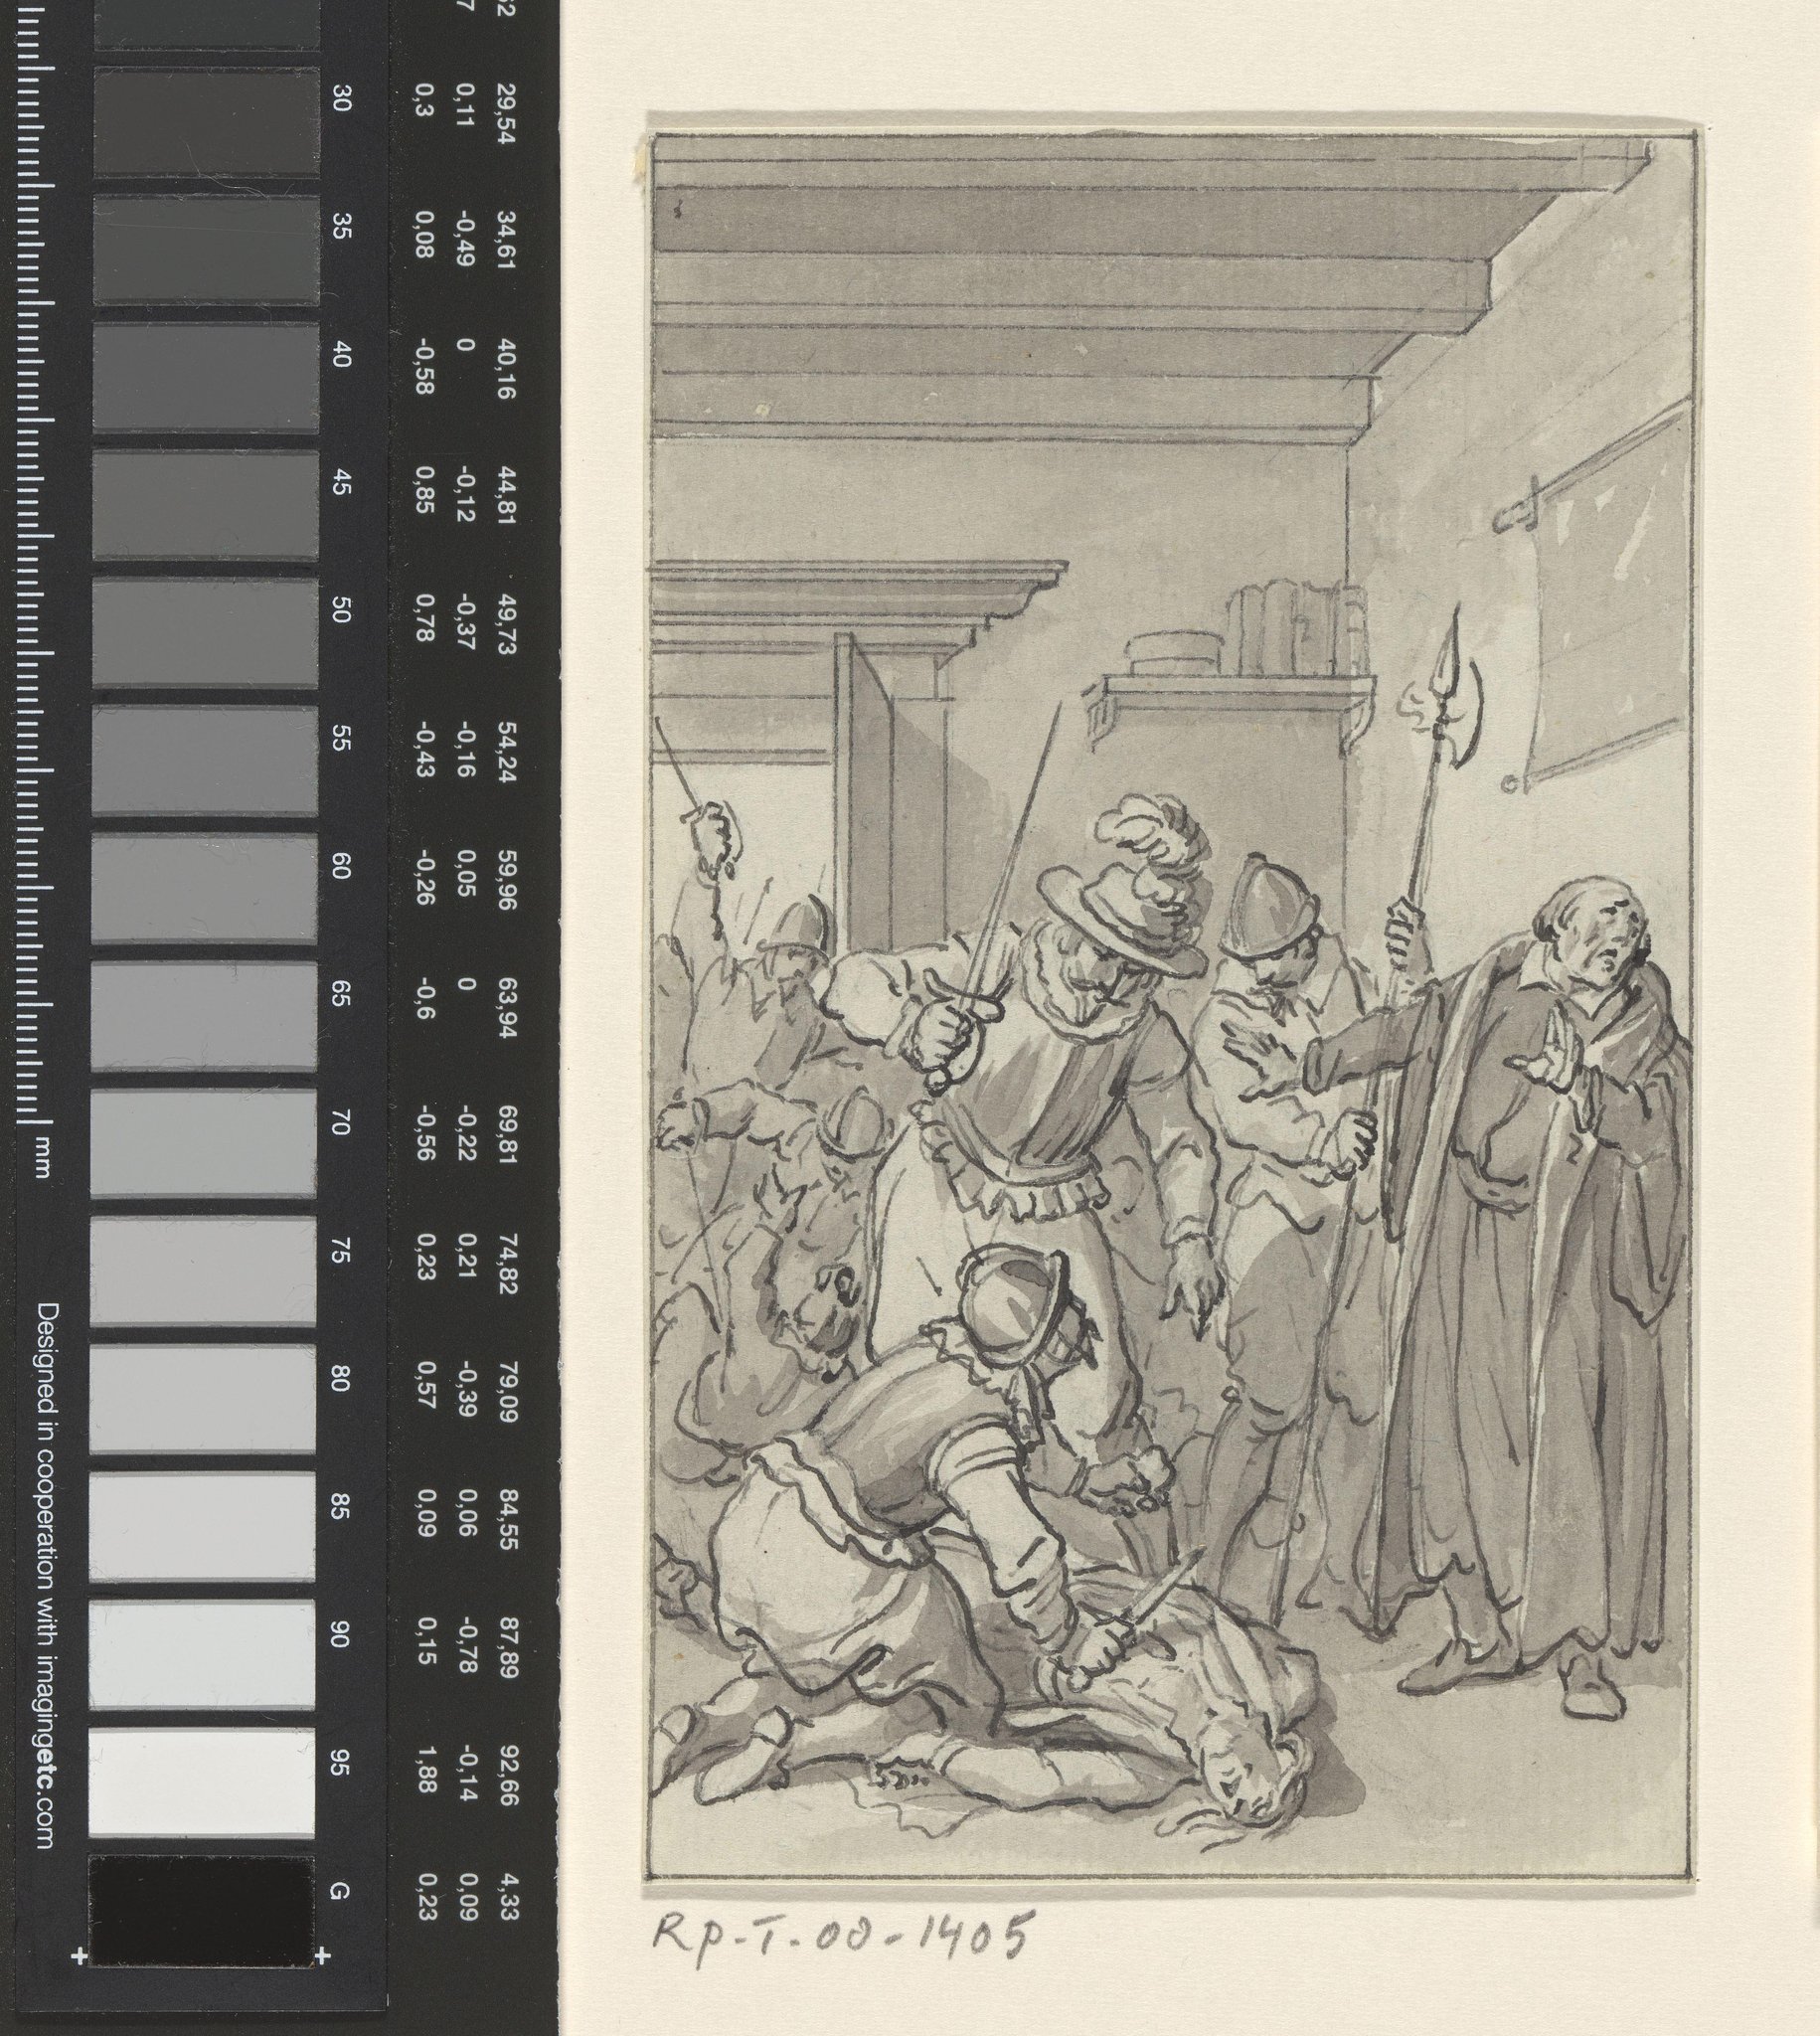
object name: history print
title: Mishandeling van de zoon van de geleerde Hortensius door de Spanjaarden te Naarden, 1 december 1572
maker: jacobus buys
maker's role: draughtsman, print maker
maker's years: 1724-1801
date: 1788-1790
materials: ink, paper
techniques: brush, pen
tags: priest, historical persons, torture, mutilation of the corpse, massacre ~ war, historical events and situations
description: De Spanjaarden doden en snijden het hart uit het lichaam van Augustinus Hortensius, de zoon van Lambertus Hortensius, rector en geschiedschrijver te Naarden, 1 december 1572. Ontwerp voor een prent.